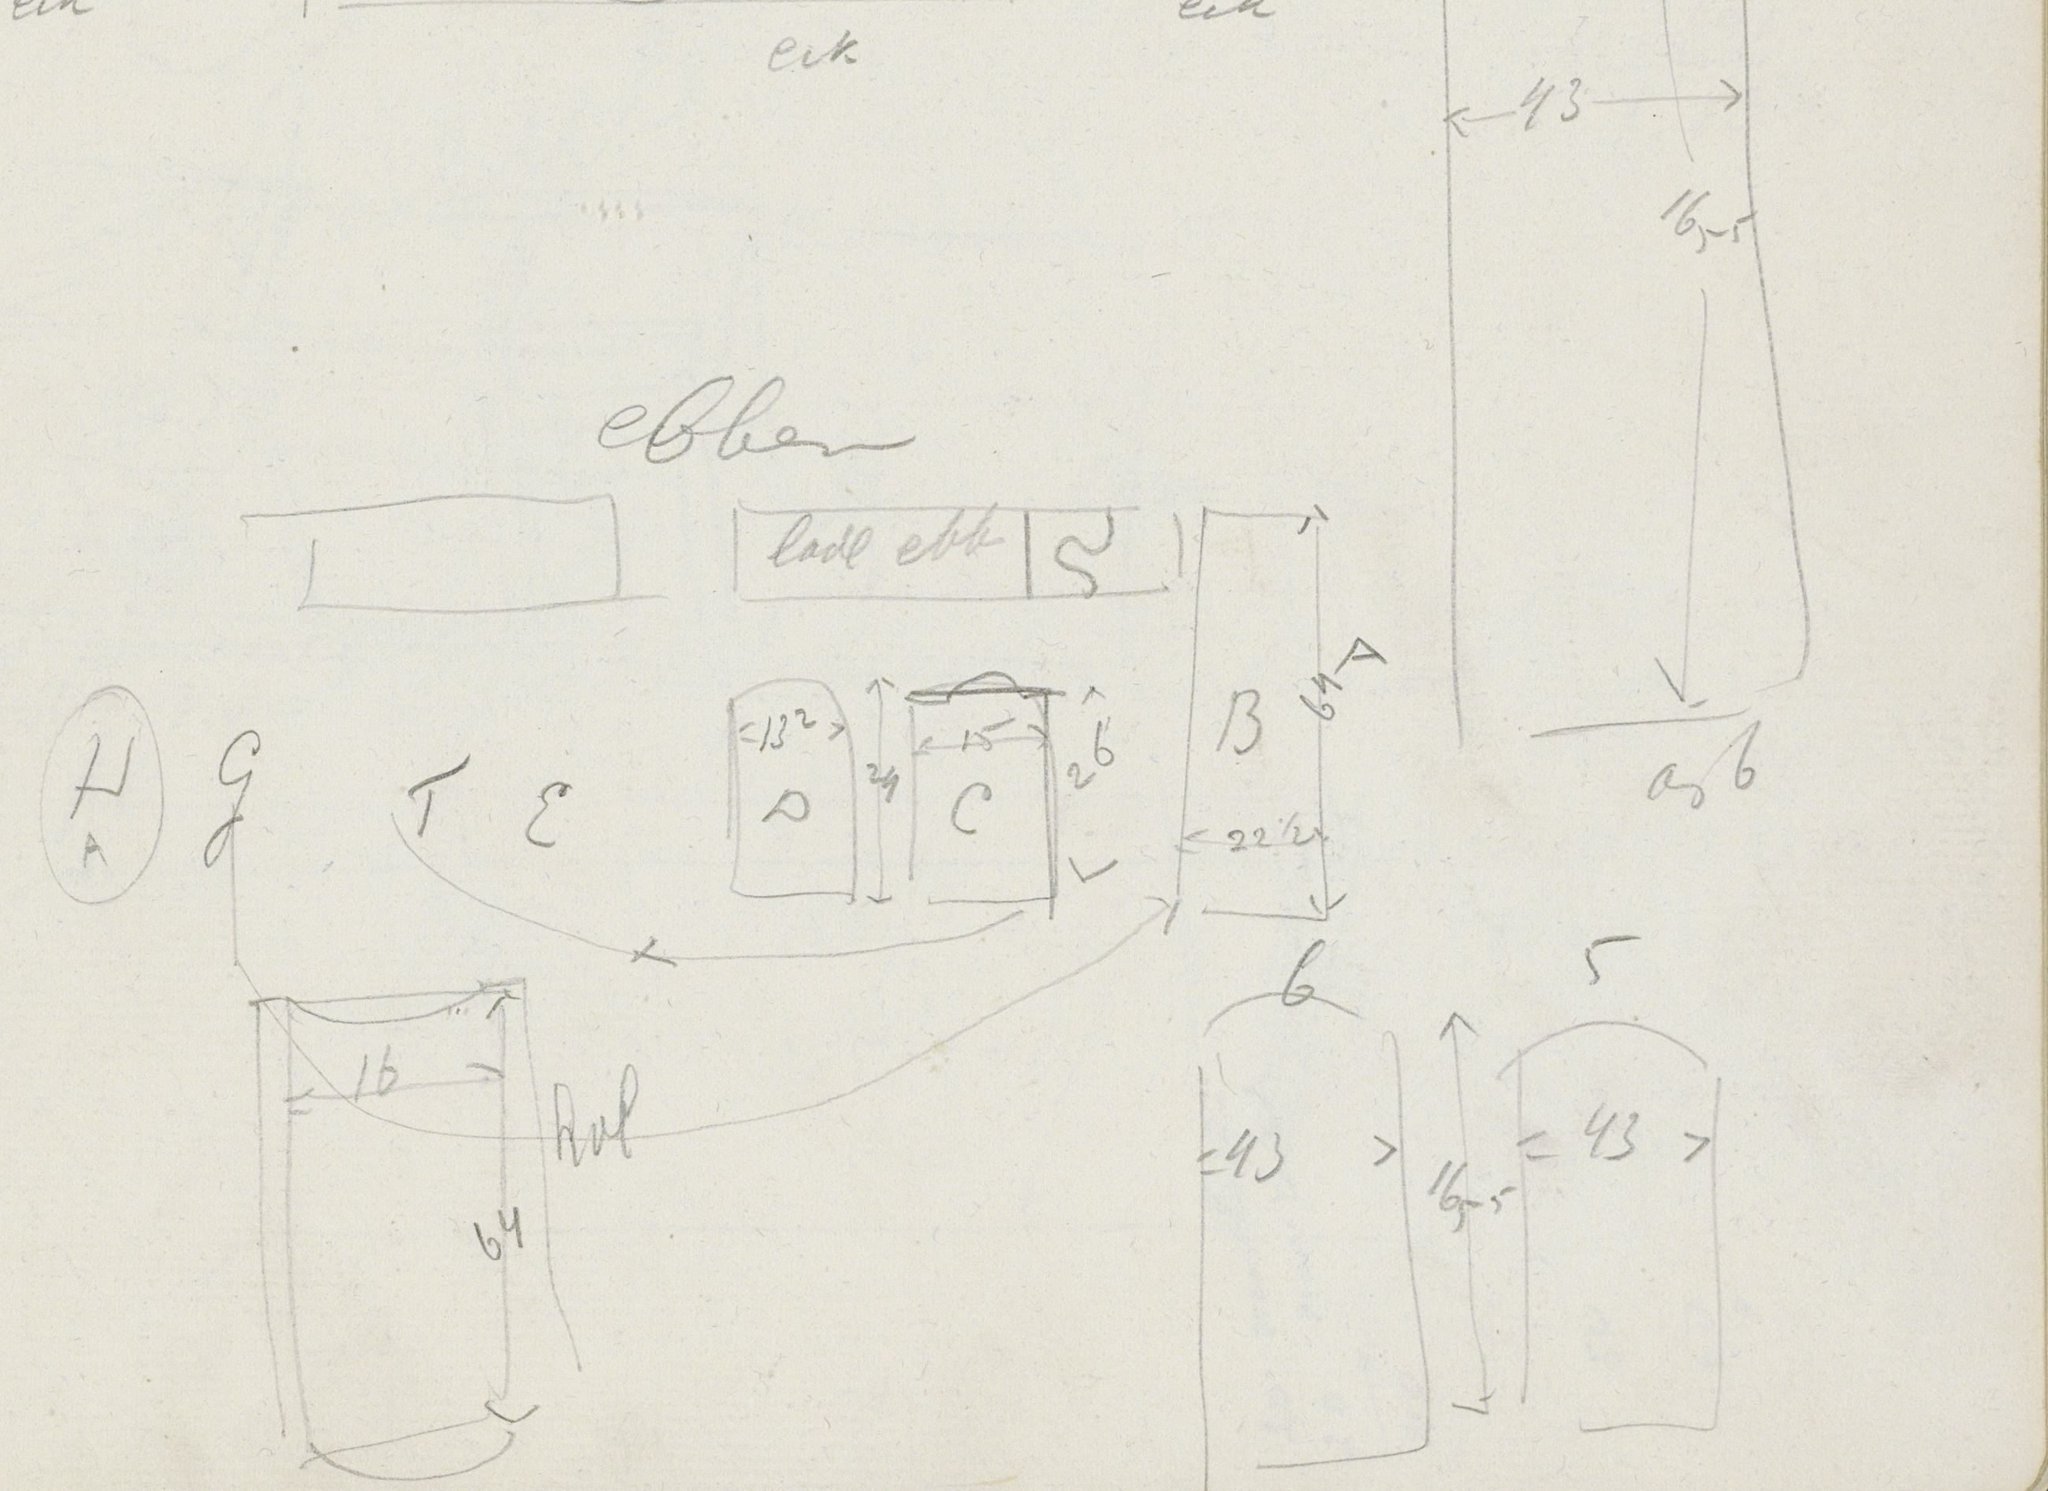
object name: sketchbook leaf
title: Ontwerpen voor een buffetwand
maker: carel adolph lion cachet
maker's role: draughtsman, print maker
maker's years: 1864-1945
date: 1905-1910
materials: paper, pencil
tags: furniture for storage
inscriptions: annotation: ‘[...]’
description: Onder andere ontwerpen voor laden. Blad 9 recto uit een schetsboek met 27 bladen.